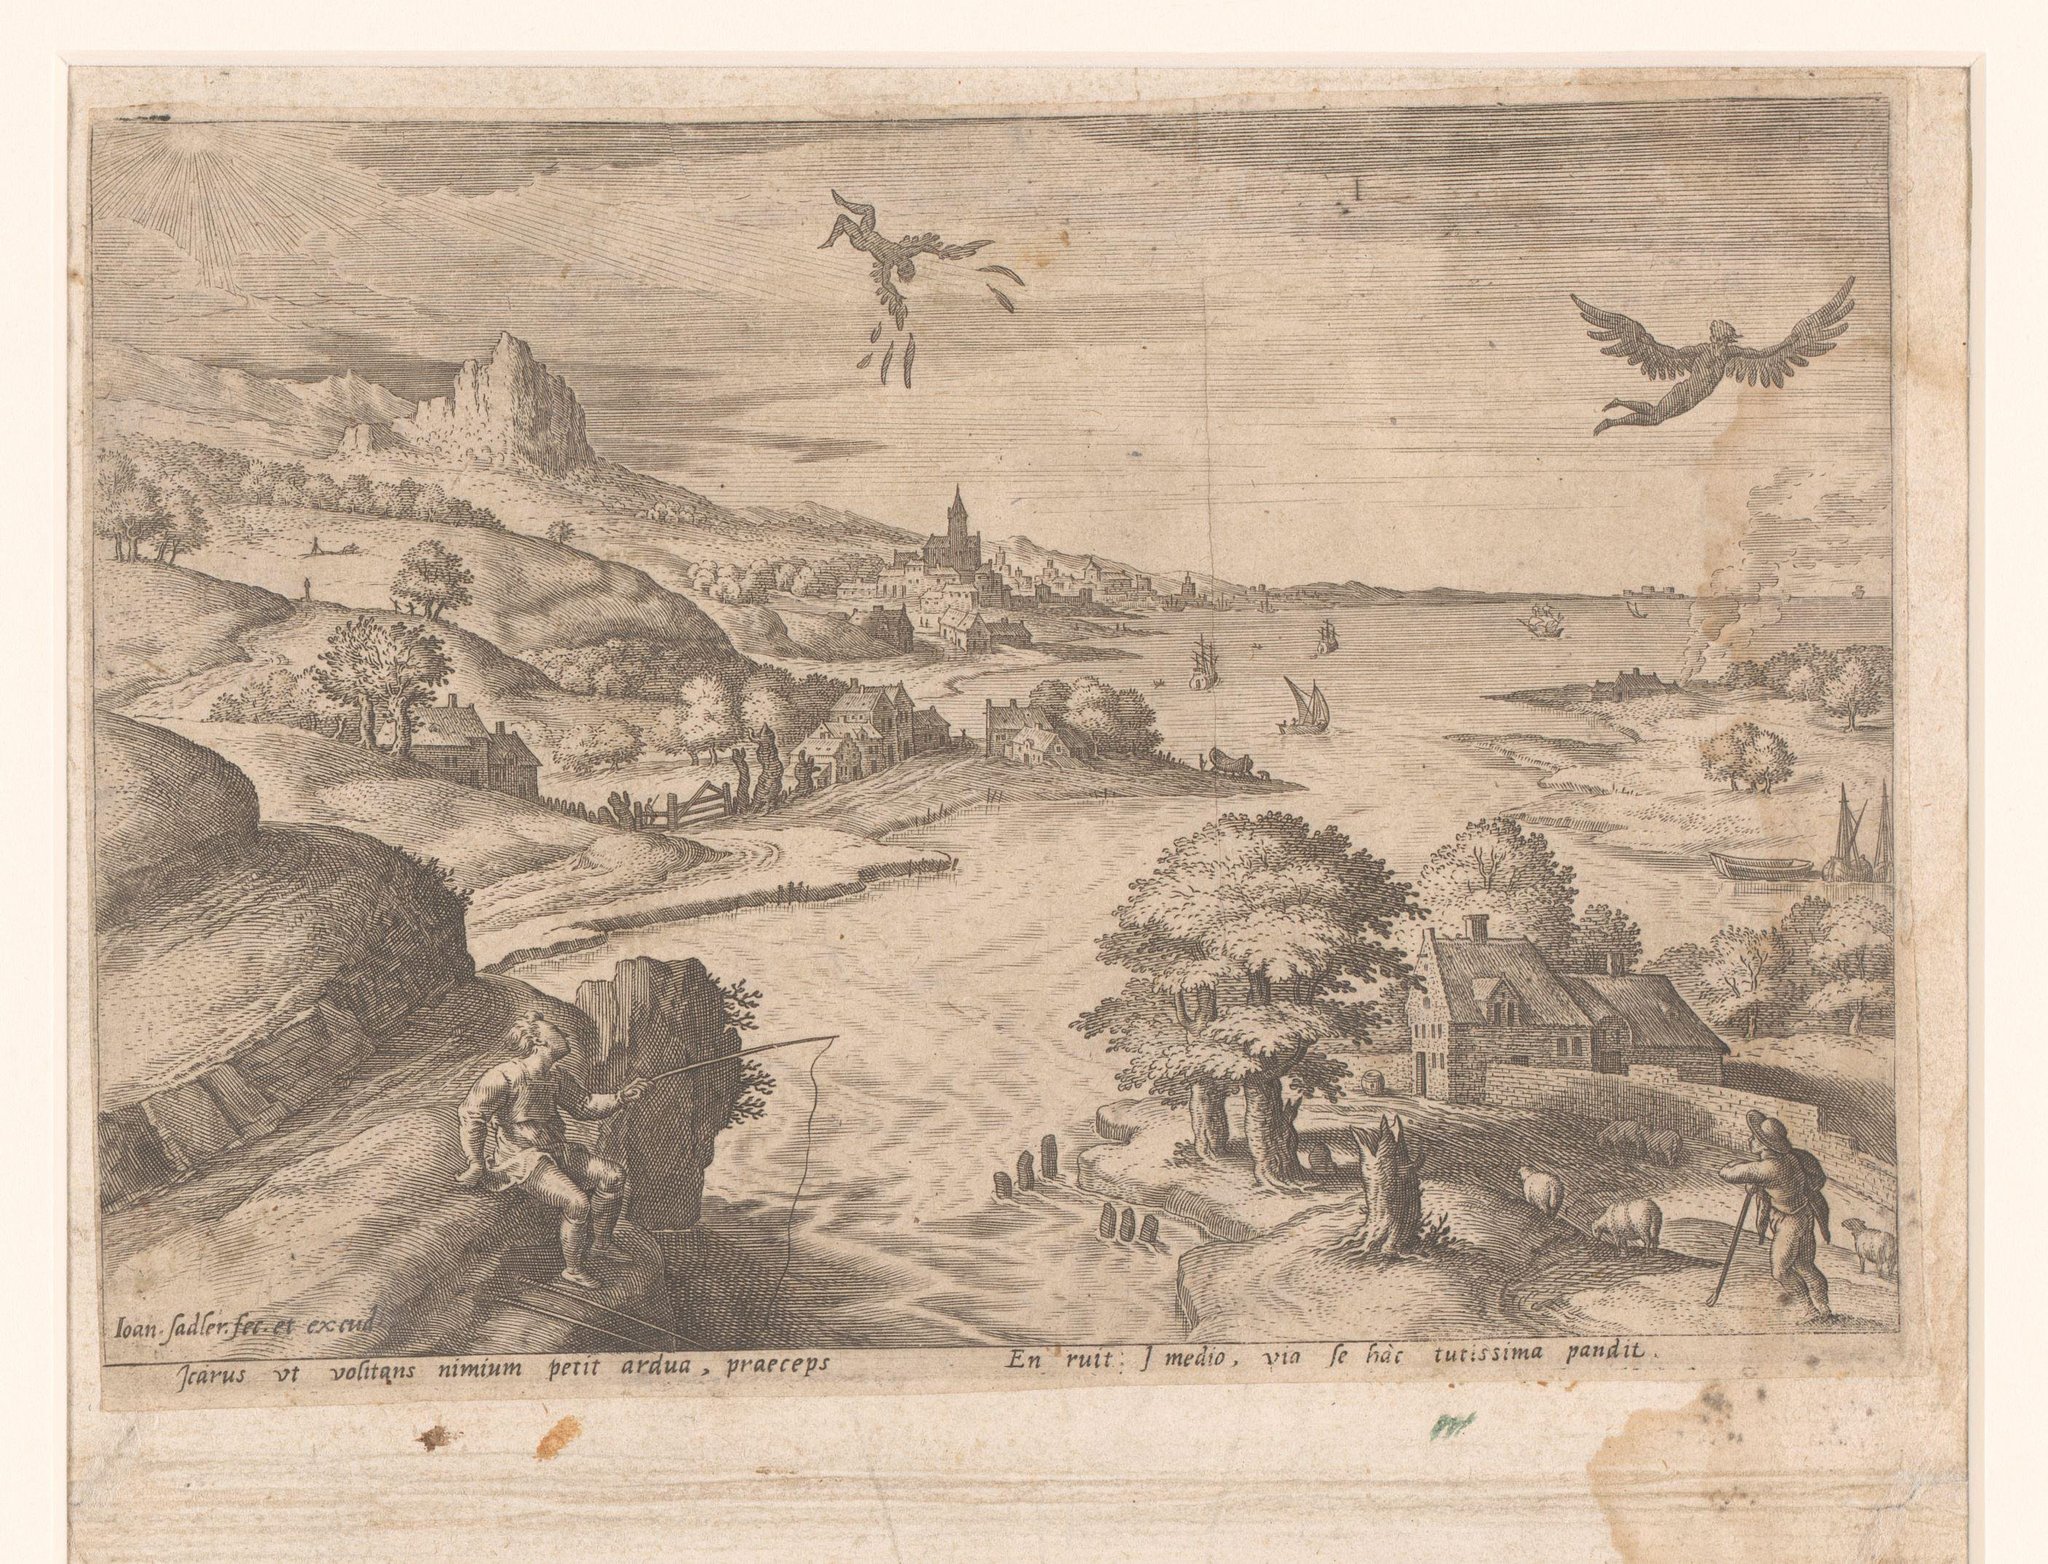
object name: album leaf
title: Landschap met Narcissus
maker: johann sadeler (i)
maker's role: print maker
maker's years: 1550-1600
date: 1570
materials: paper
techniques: engraving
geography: antwerp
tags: narcissus changed into a narcissus: when narcissus is pining away for the love of his image reflected from the water, he is changed into a narcissus (ovid, metamorphoses iii 510)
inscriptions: inscription: ‘80’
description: Gemonteerd op 16de-eeuws albumblad met op recto twee etsen van Etienne Duperac.